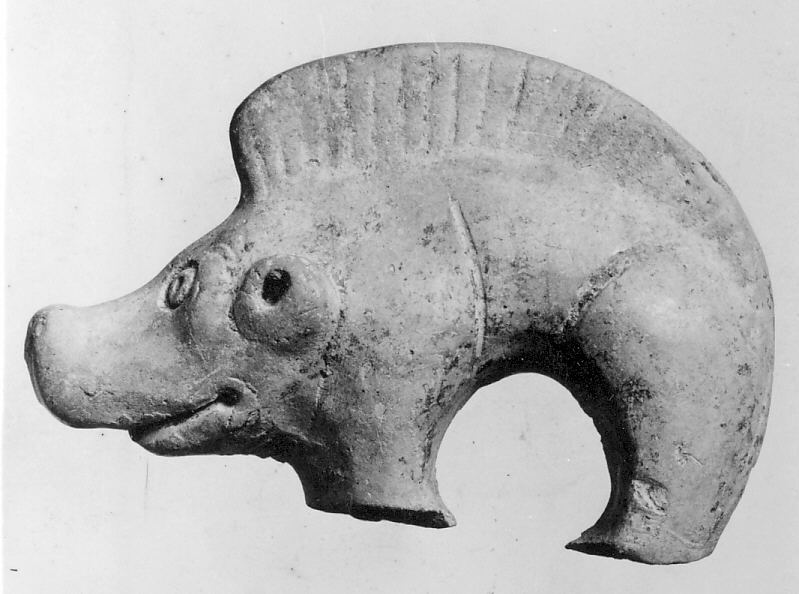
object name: handle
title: Pig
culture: central asian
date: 1101-1133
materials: earthenware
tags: pigs